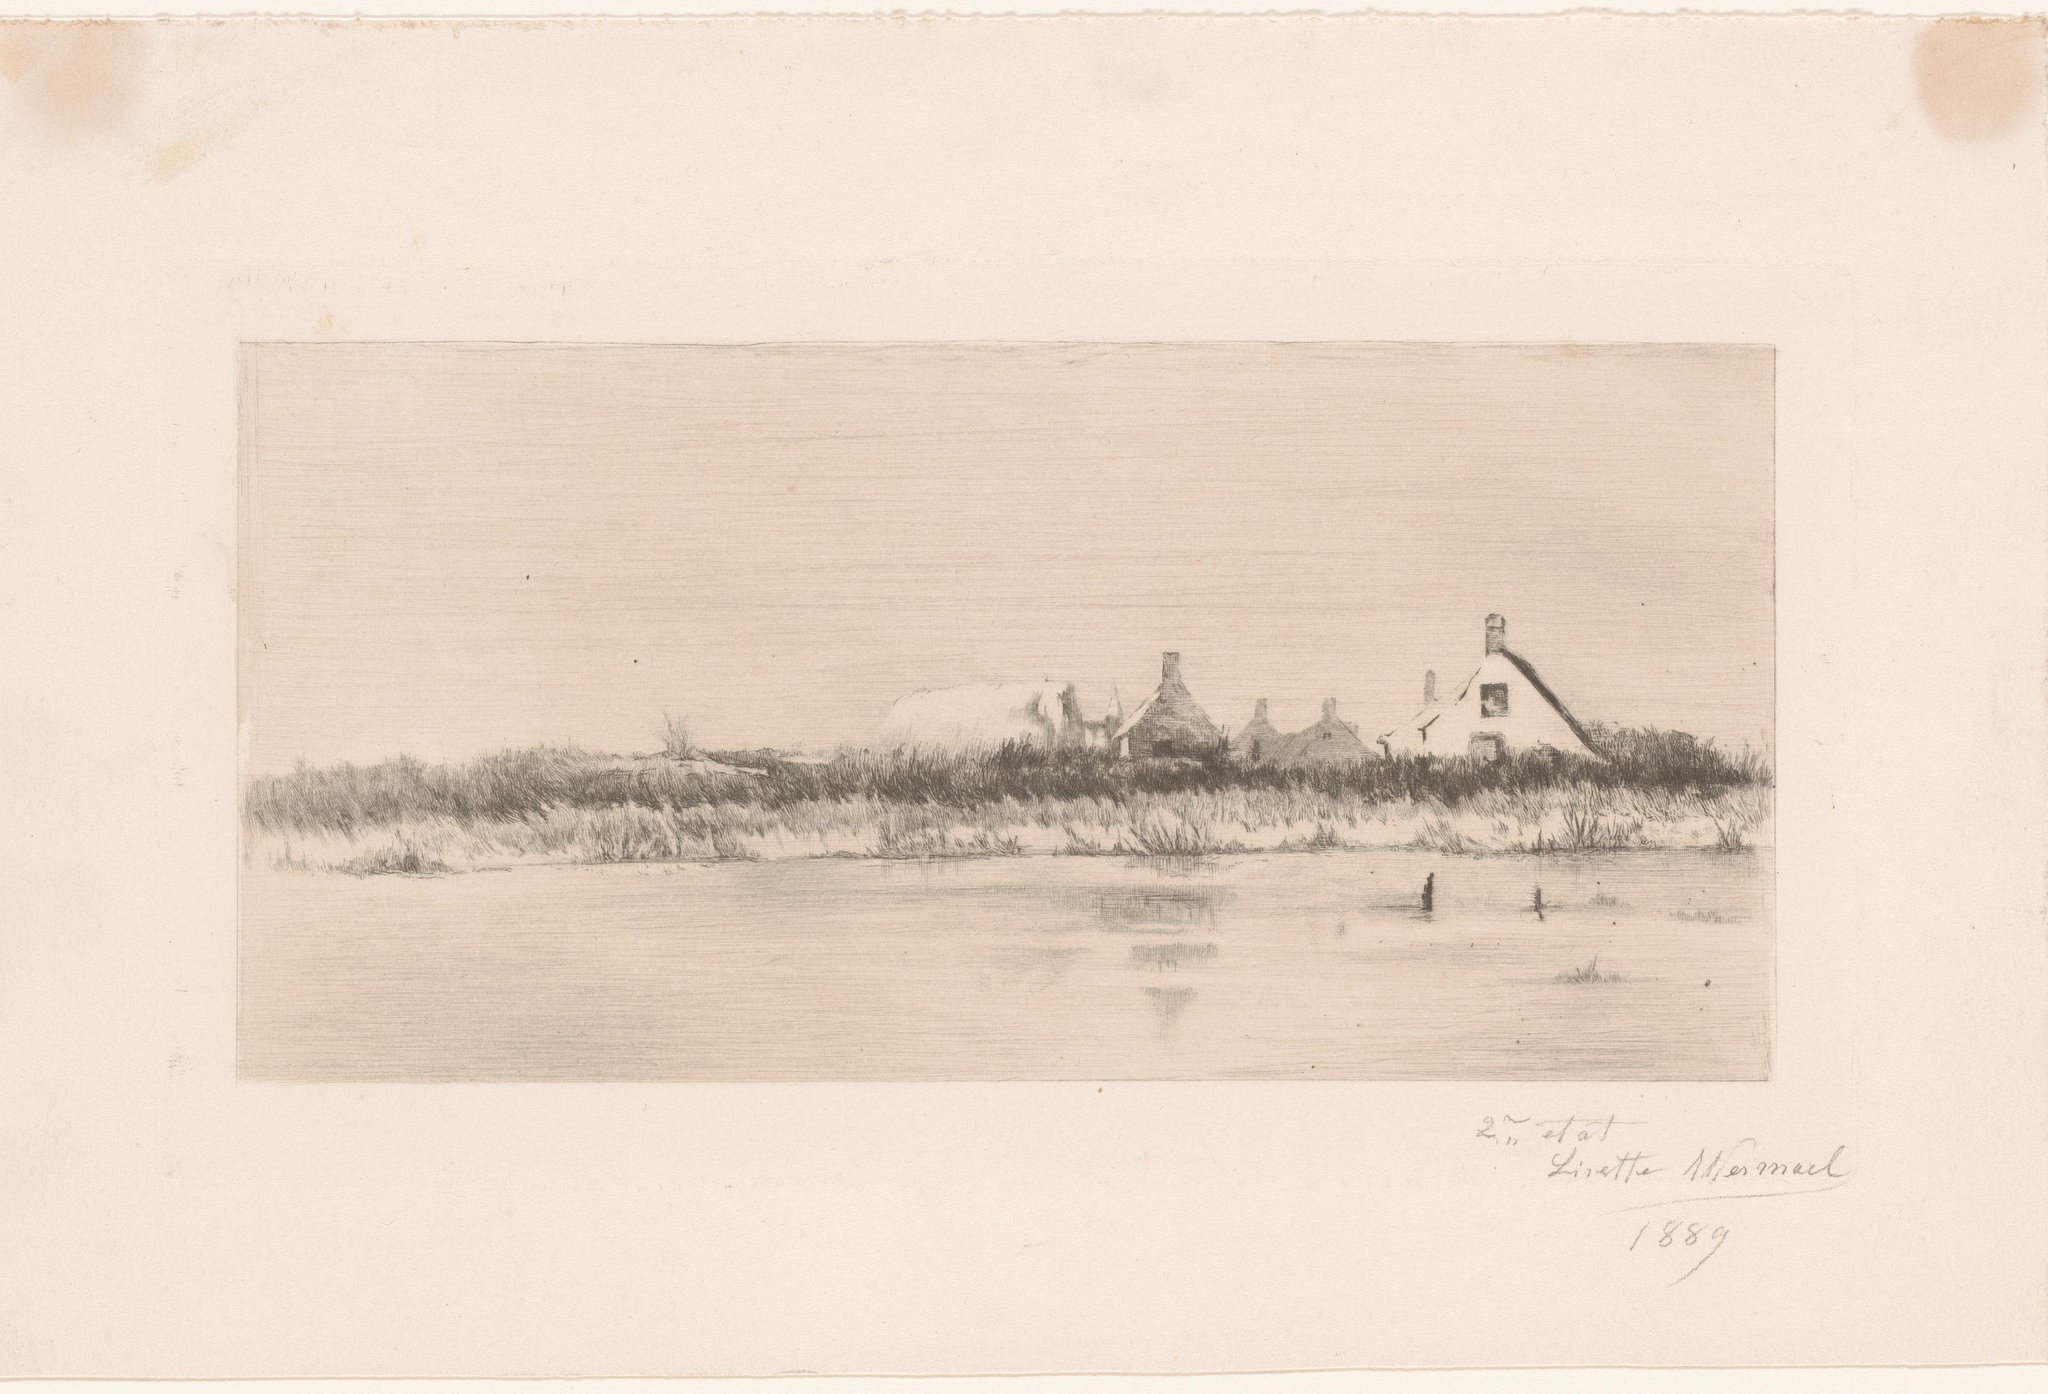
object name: print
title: Gezicht op Klemskerke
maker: lisette wesmael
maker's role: print maker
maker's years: 1861-1953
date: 1889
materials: paper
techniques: etching, intaglio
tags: dune coast, de haan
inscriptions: collector's mark: Lugt 2228